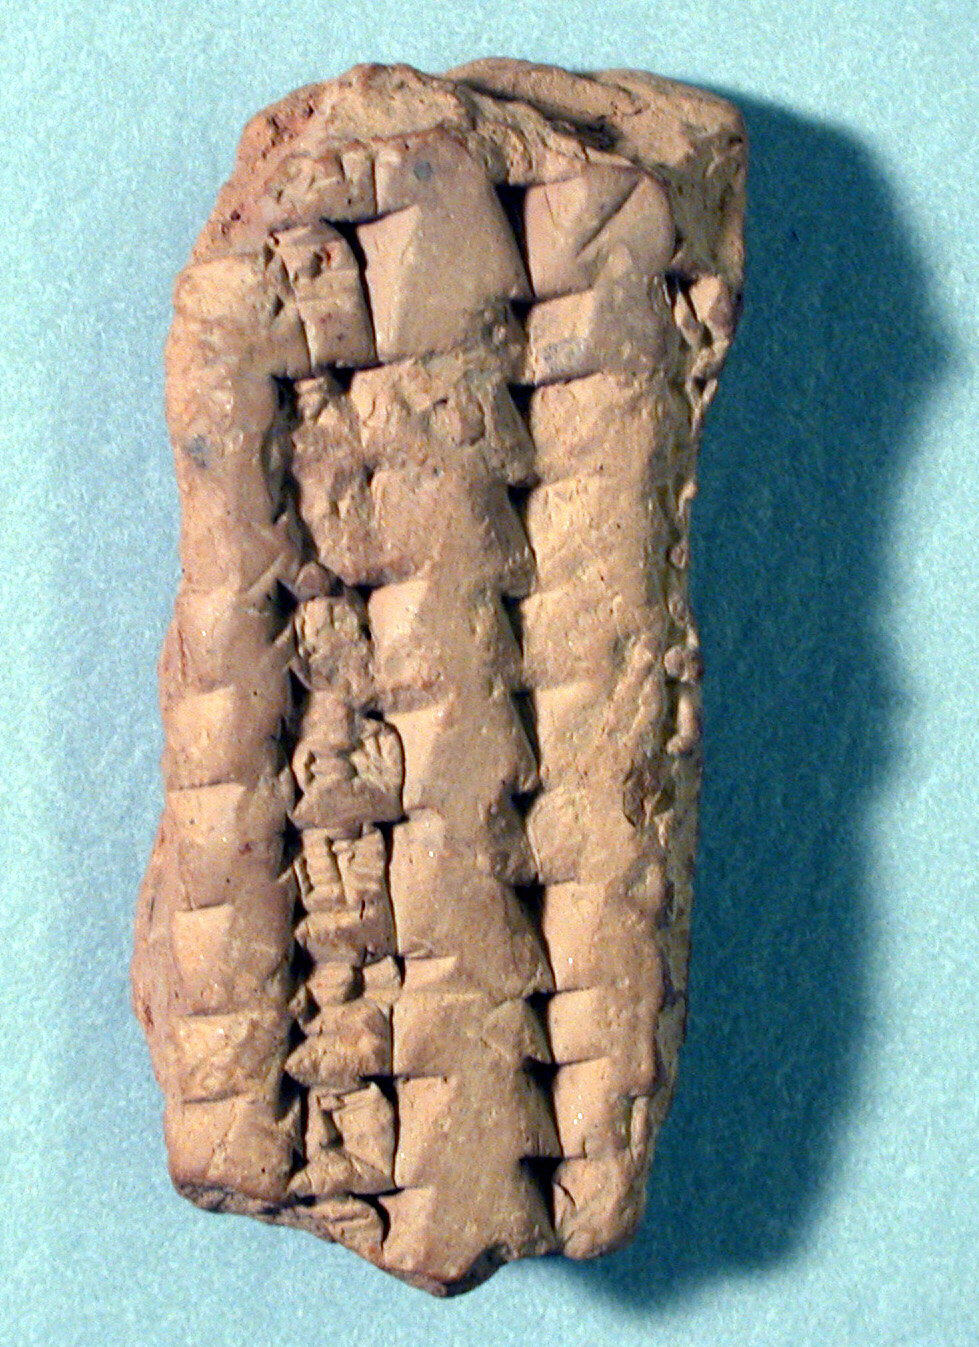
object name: cuneiform tablet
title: Cuneiform tablet: fragment of Syllabary B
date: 333-1 BCE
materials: clay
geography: mesopotamia